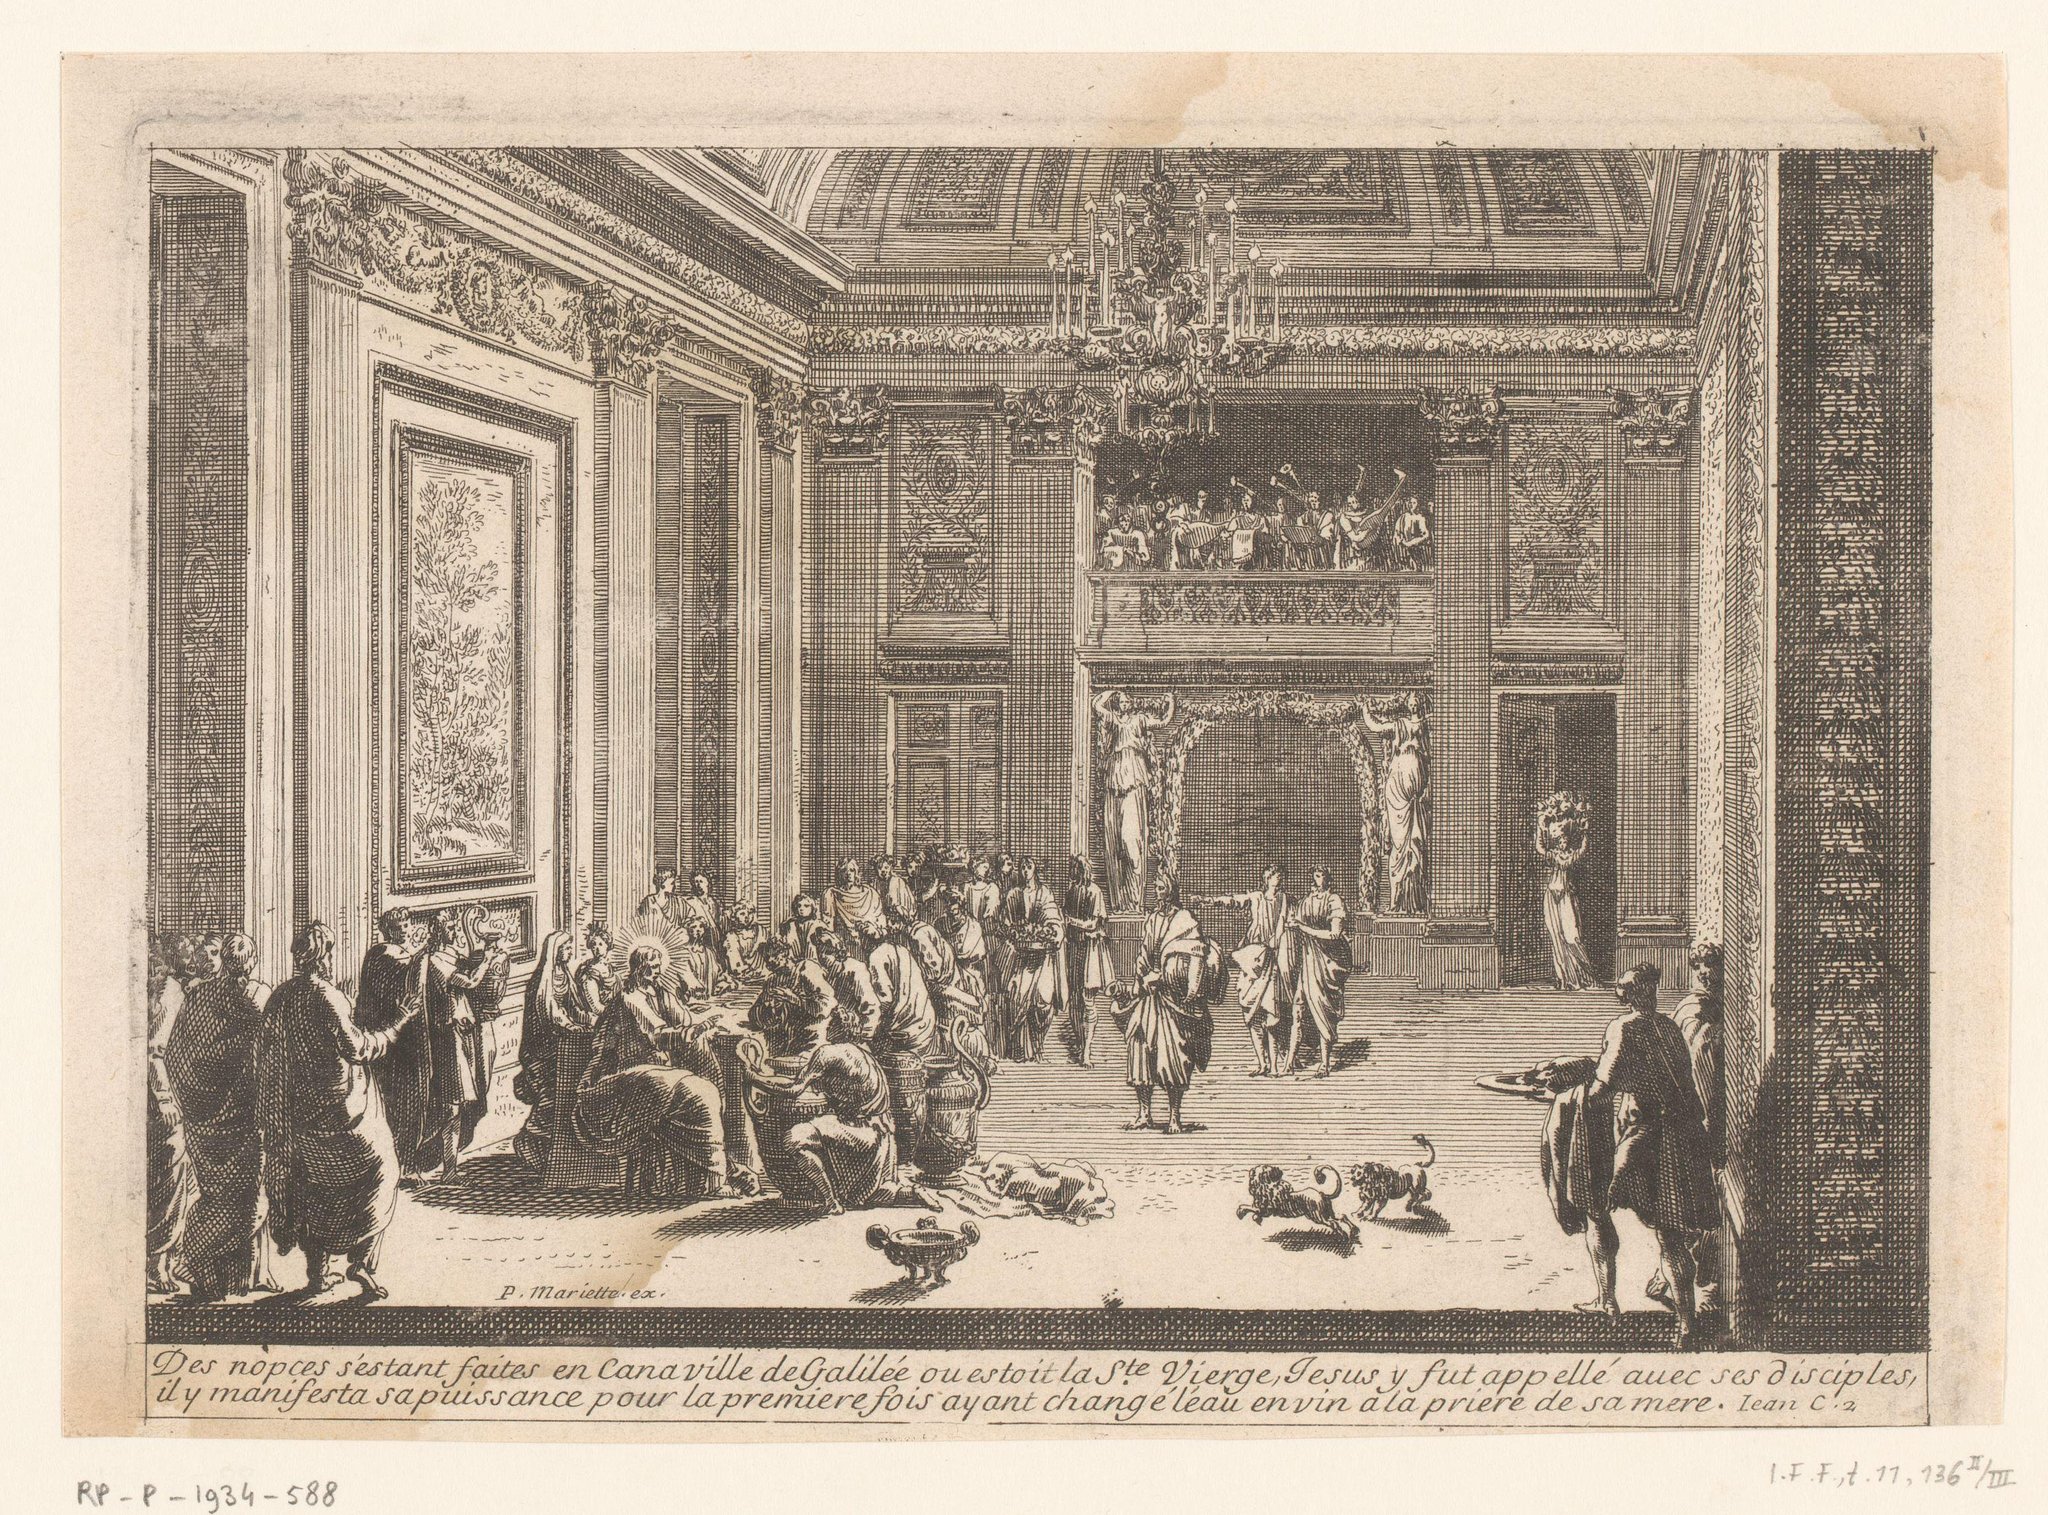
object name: print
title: La vie de Jésus-Christ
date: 1628-1682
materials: paper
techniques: etching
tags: christ orders (six) jars to be filled with water ~ marriage-feast at cana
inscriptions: collector's mark: Lugt 2228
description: Maakt deel uit van een zesdelige serie met scènes uit het leven van Christus, opgedragen aan François de Rostaing. Enkel de laatste plaat uit de serie is door Lepautre gesigneerd. Zie IFF 17e siècle, p. 101.